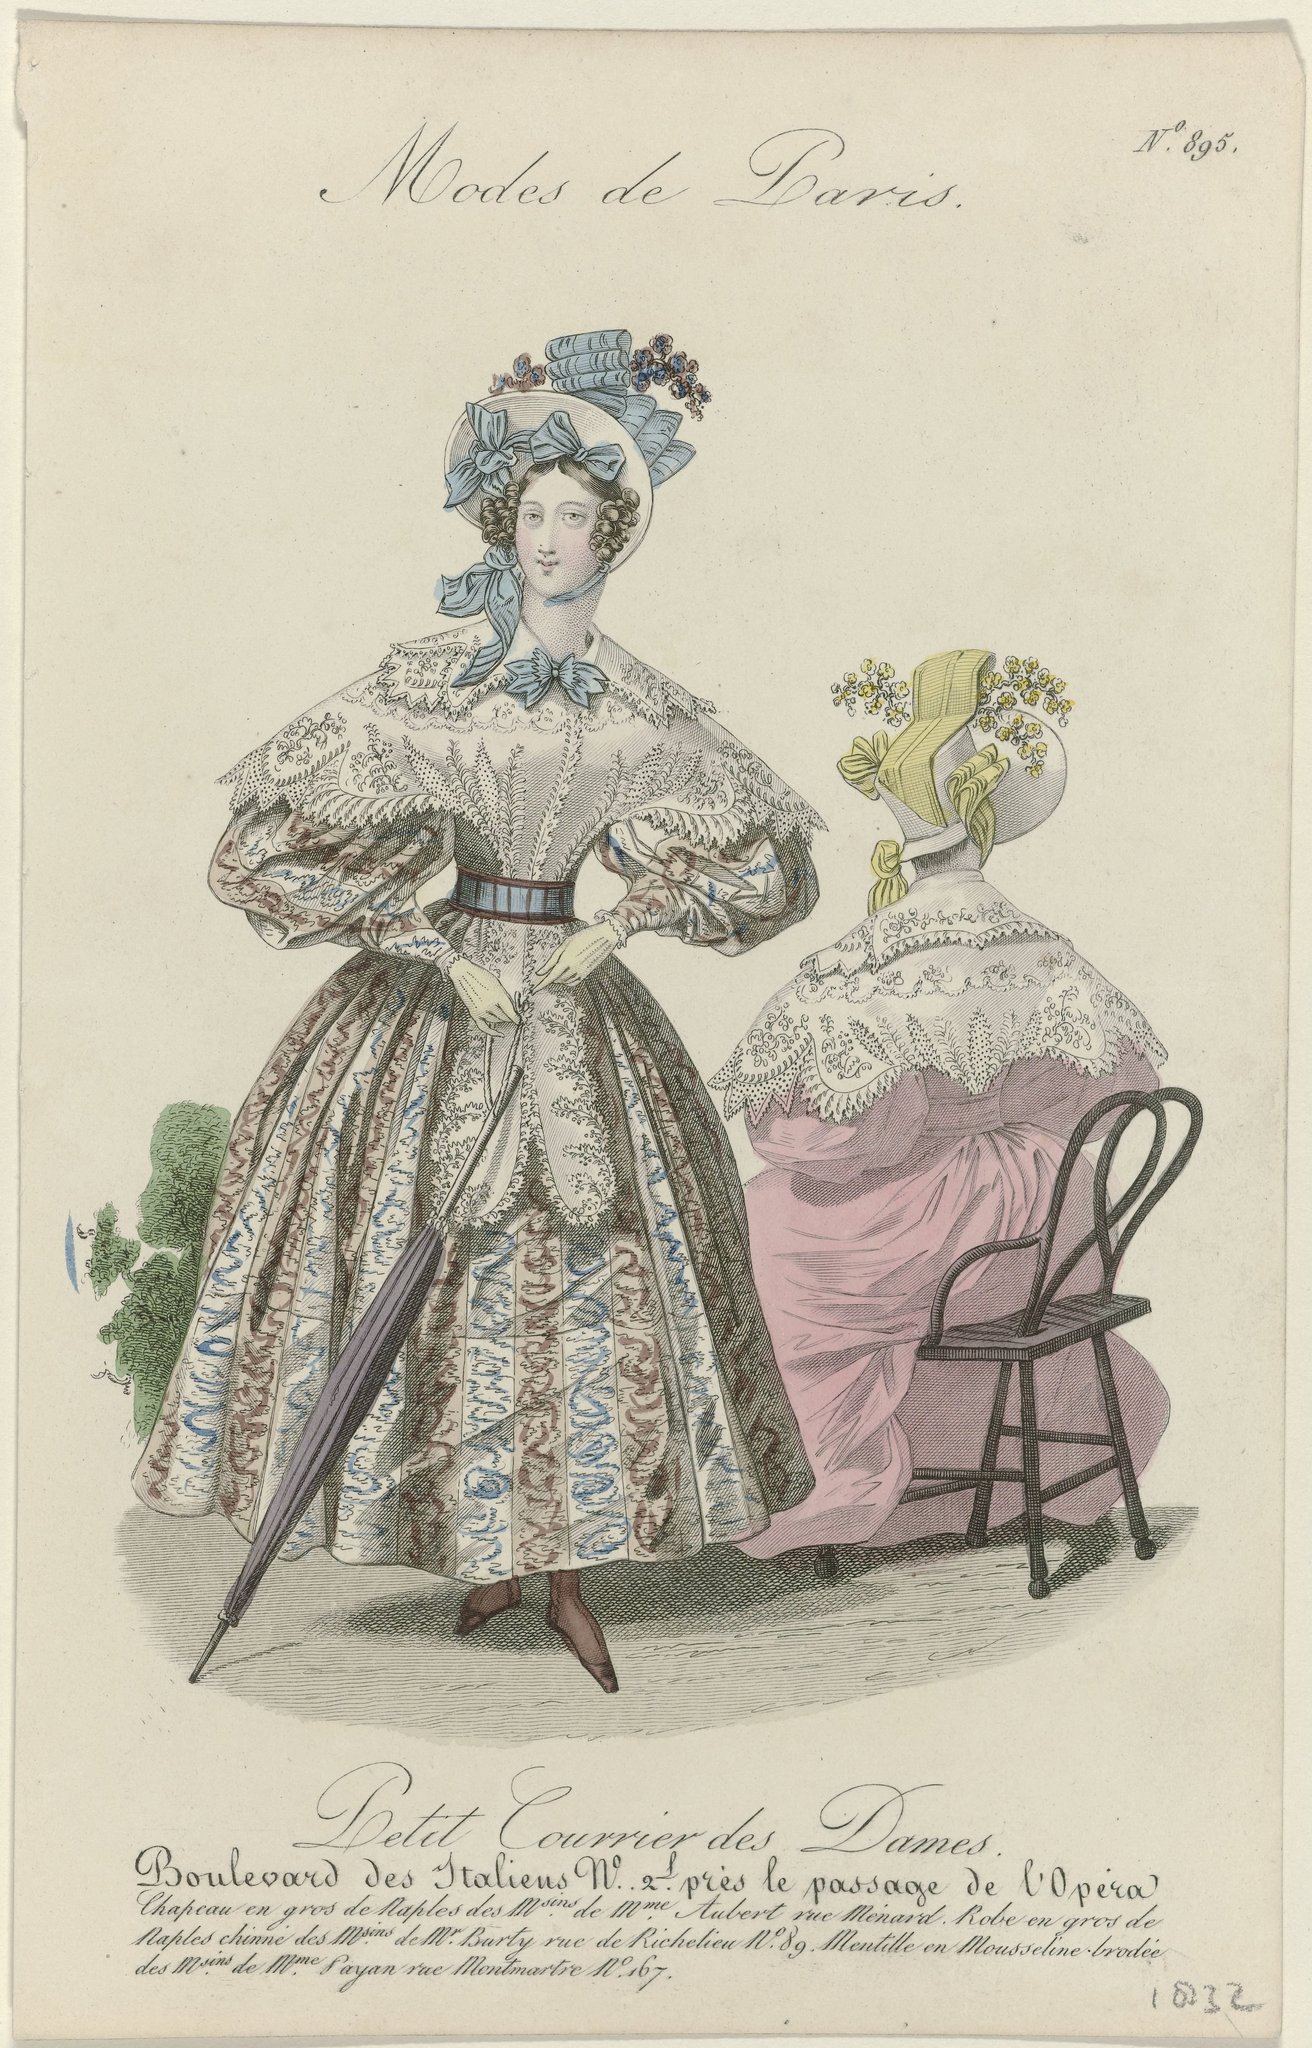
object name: fashion print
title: Petit Courrier des Dames, 1832, No. 895 : Chapeau en gros de Naples (...)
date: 1832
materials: paper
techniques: engraving, hand coloring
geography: paris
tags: embroidery (ornamentation) (+ women's clothes), clothing for the upper part of the body (mantelet) (+ women's clothes), fashion plates, head-gear: hat (+ women's clothes), dress, gown (+ women's clothes), parasol, sunshade (+ women's clothes)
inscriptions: title: ‘Modes de Paris.’, title: ‘Petit Courrier des Dames.’, address: ‘Boulevard des Italiens No.2 près le passage de l'Opèra.’, caption: ‘Chapeau en gros de Naples des M.sins de M.me Aubert rue Ménard. Robe en gros de Naples chinné des M.sins de Mr. Burty rue de Richelieu No. 89. Mentille en Mousseline brodée des M. sins de M.me Payan rue Montmartre No. 167.’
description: Hoed van 'gros de Naples' uit de winkels van Aubert. Japon van gechineerde (?) 'gros de Naples' uit de winkels van Mr Burty. 'Mantille' van geborduurde mousseline uit de winkels van Mme Payan. Verdere accessoires: handschoenen, parasol. Prent uit het modetijdschrift Petit Courrier des Dames (1821-1868).